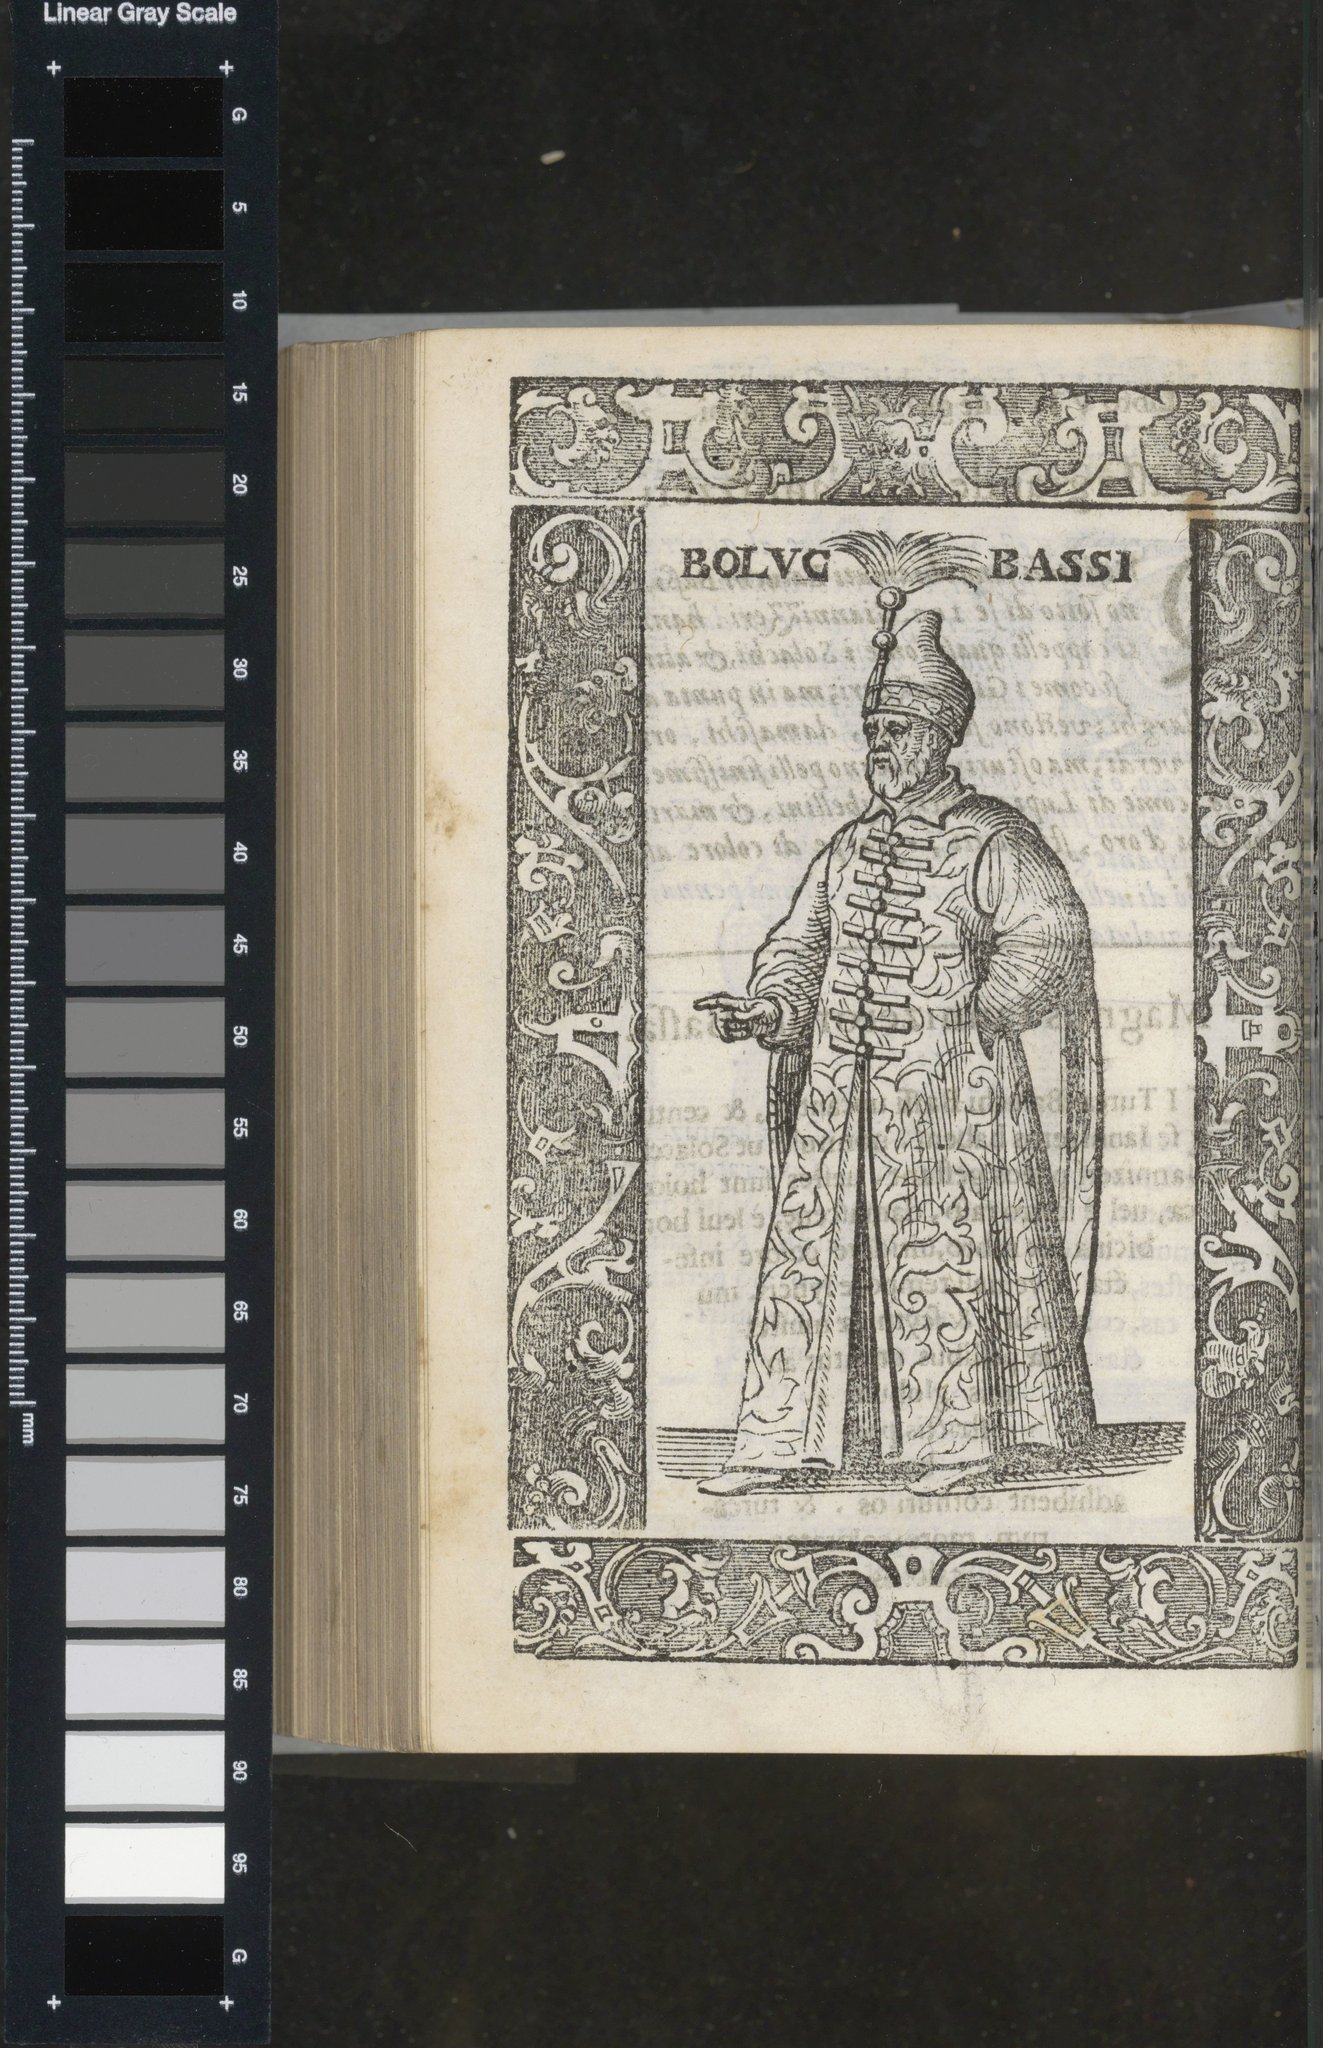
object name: costume print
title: Habiti antichi, et moderni di tutto il mondo...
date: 1598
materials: paper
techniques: woodcut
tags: fashion plates